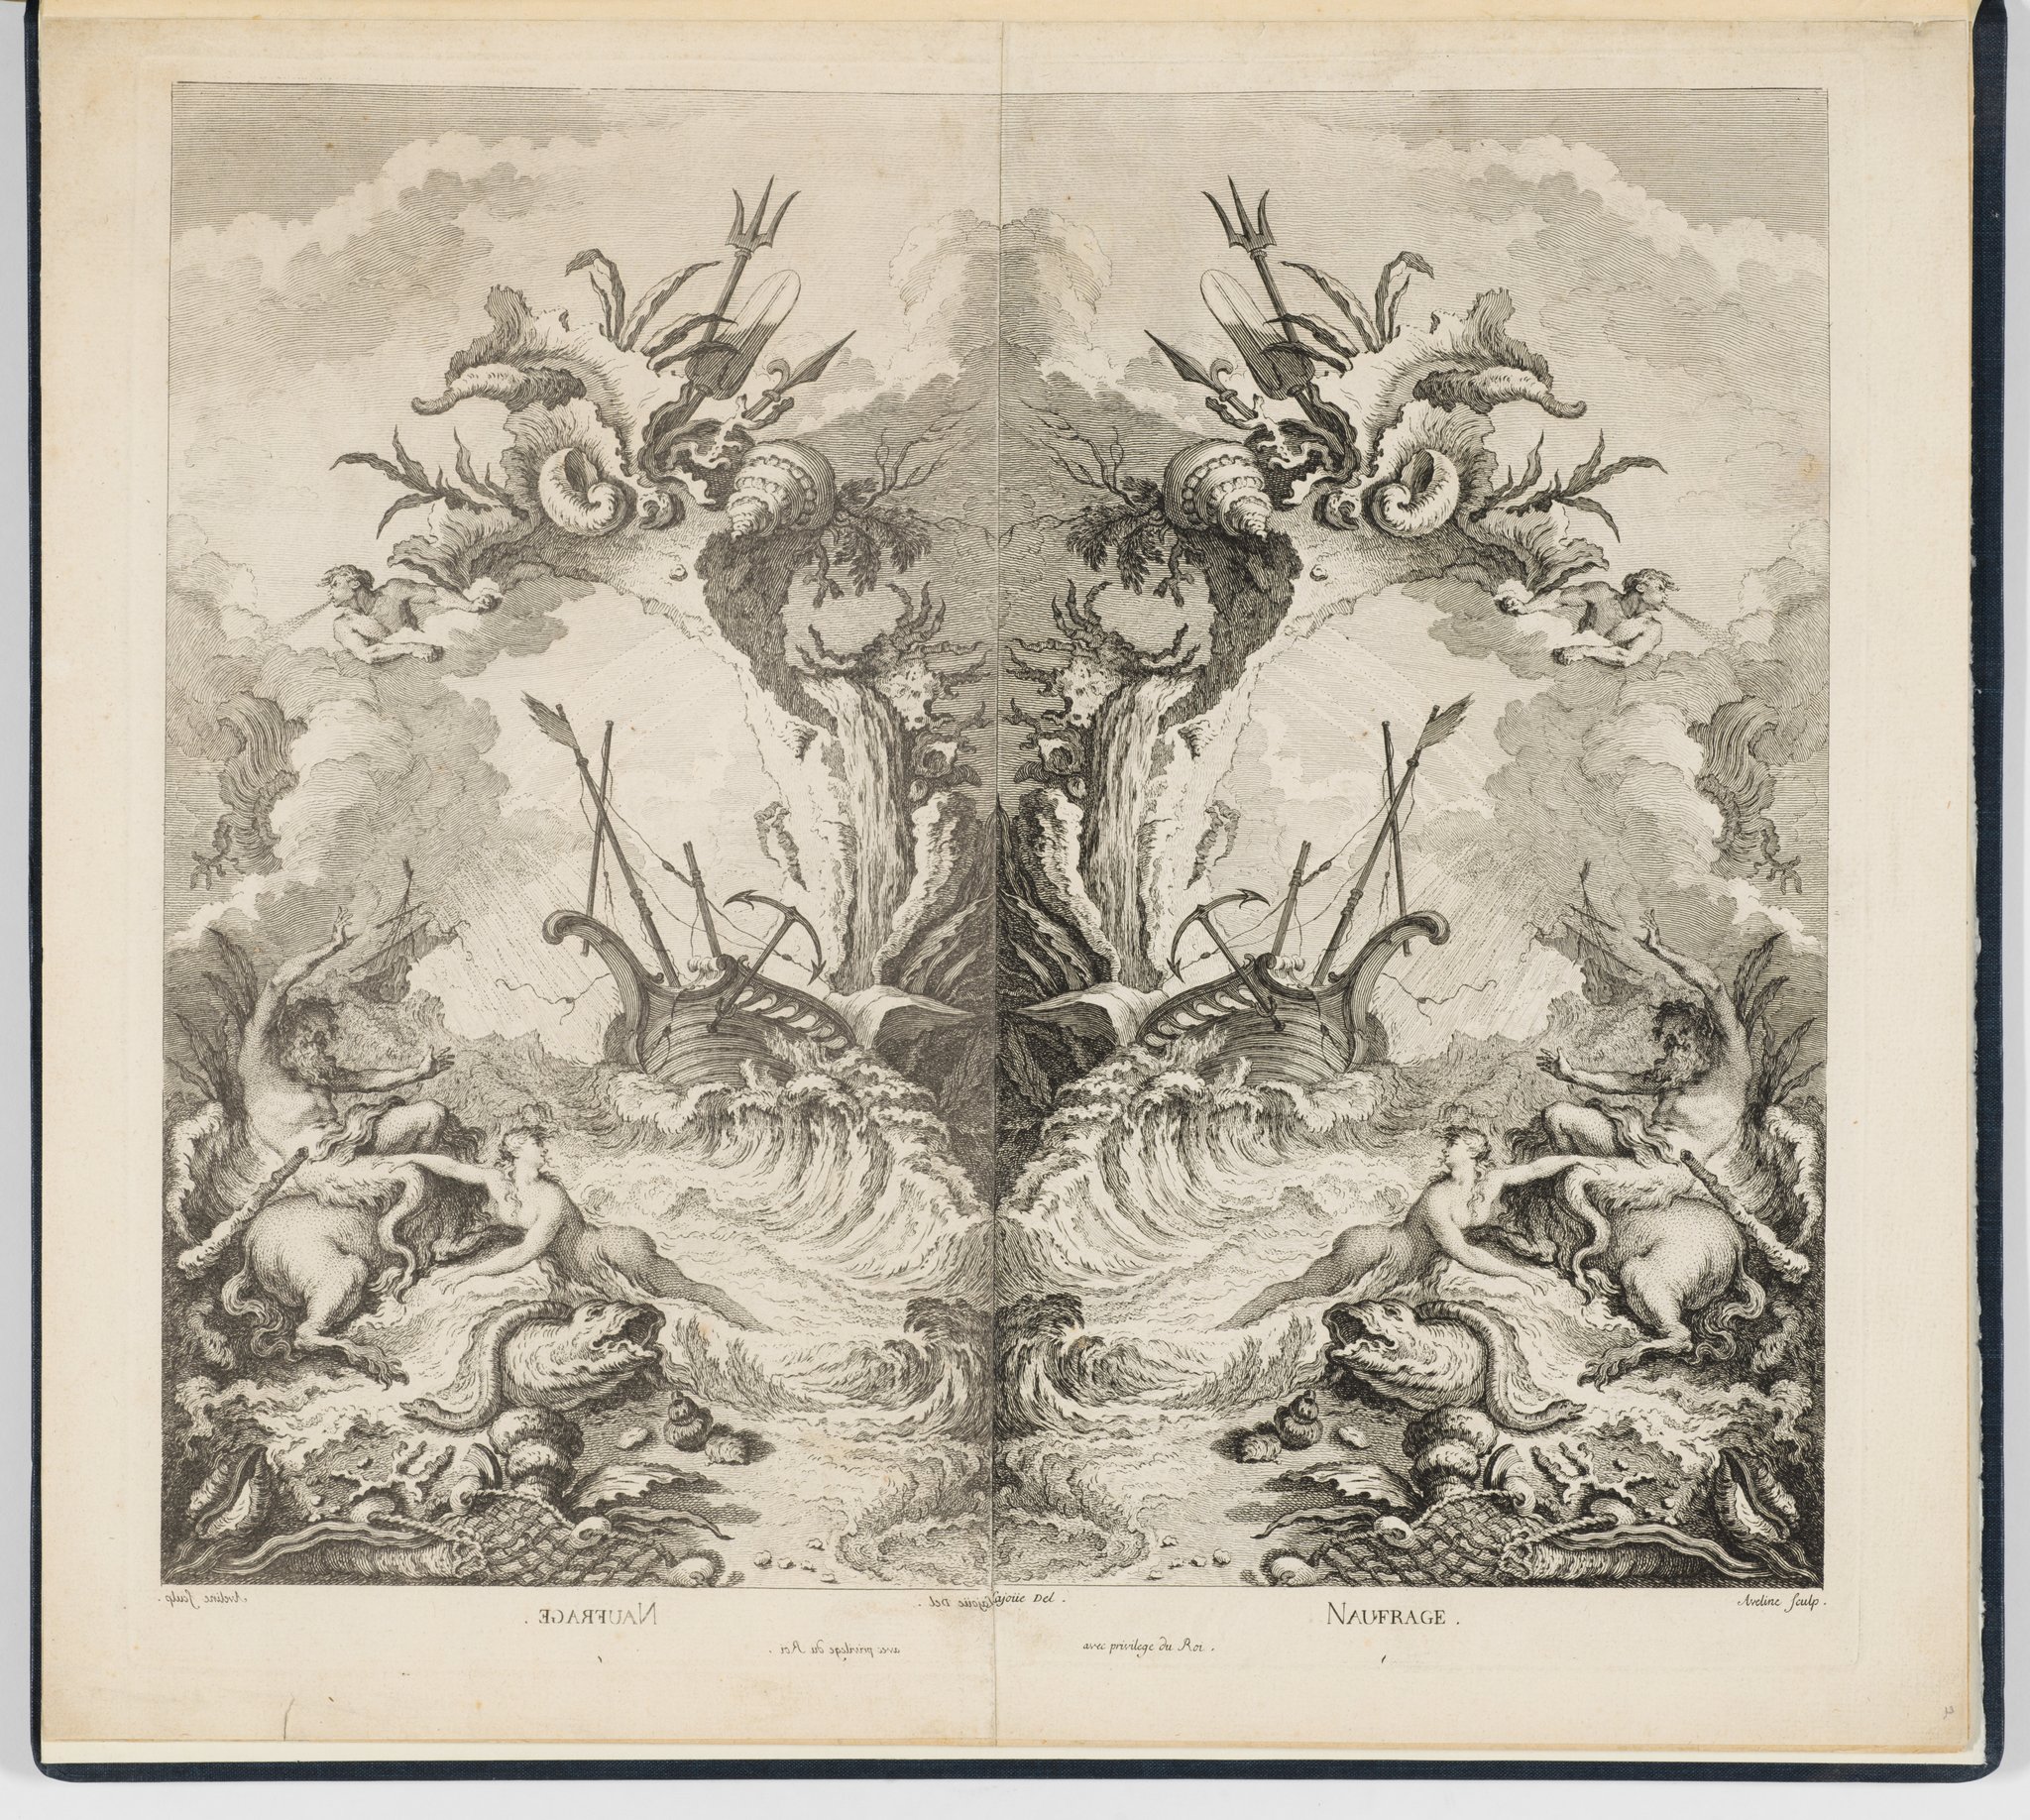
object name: book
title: [Livre Nouveau de Douze Morceaux de Fantaisie]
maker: jacques de la joue the younger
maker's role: artist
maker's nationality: french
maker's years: 1686-1761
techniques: etching